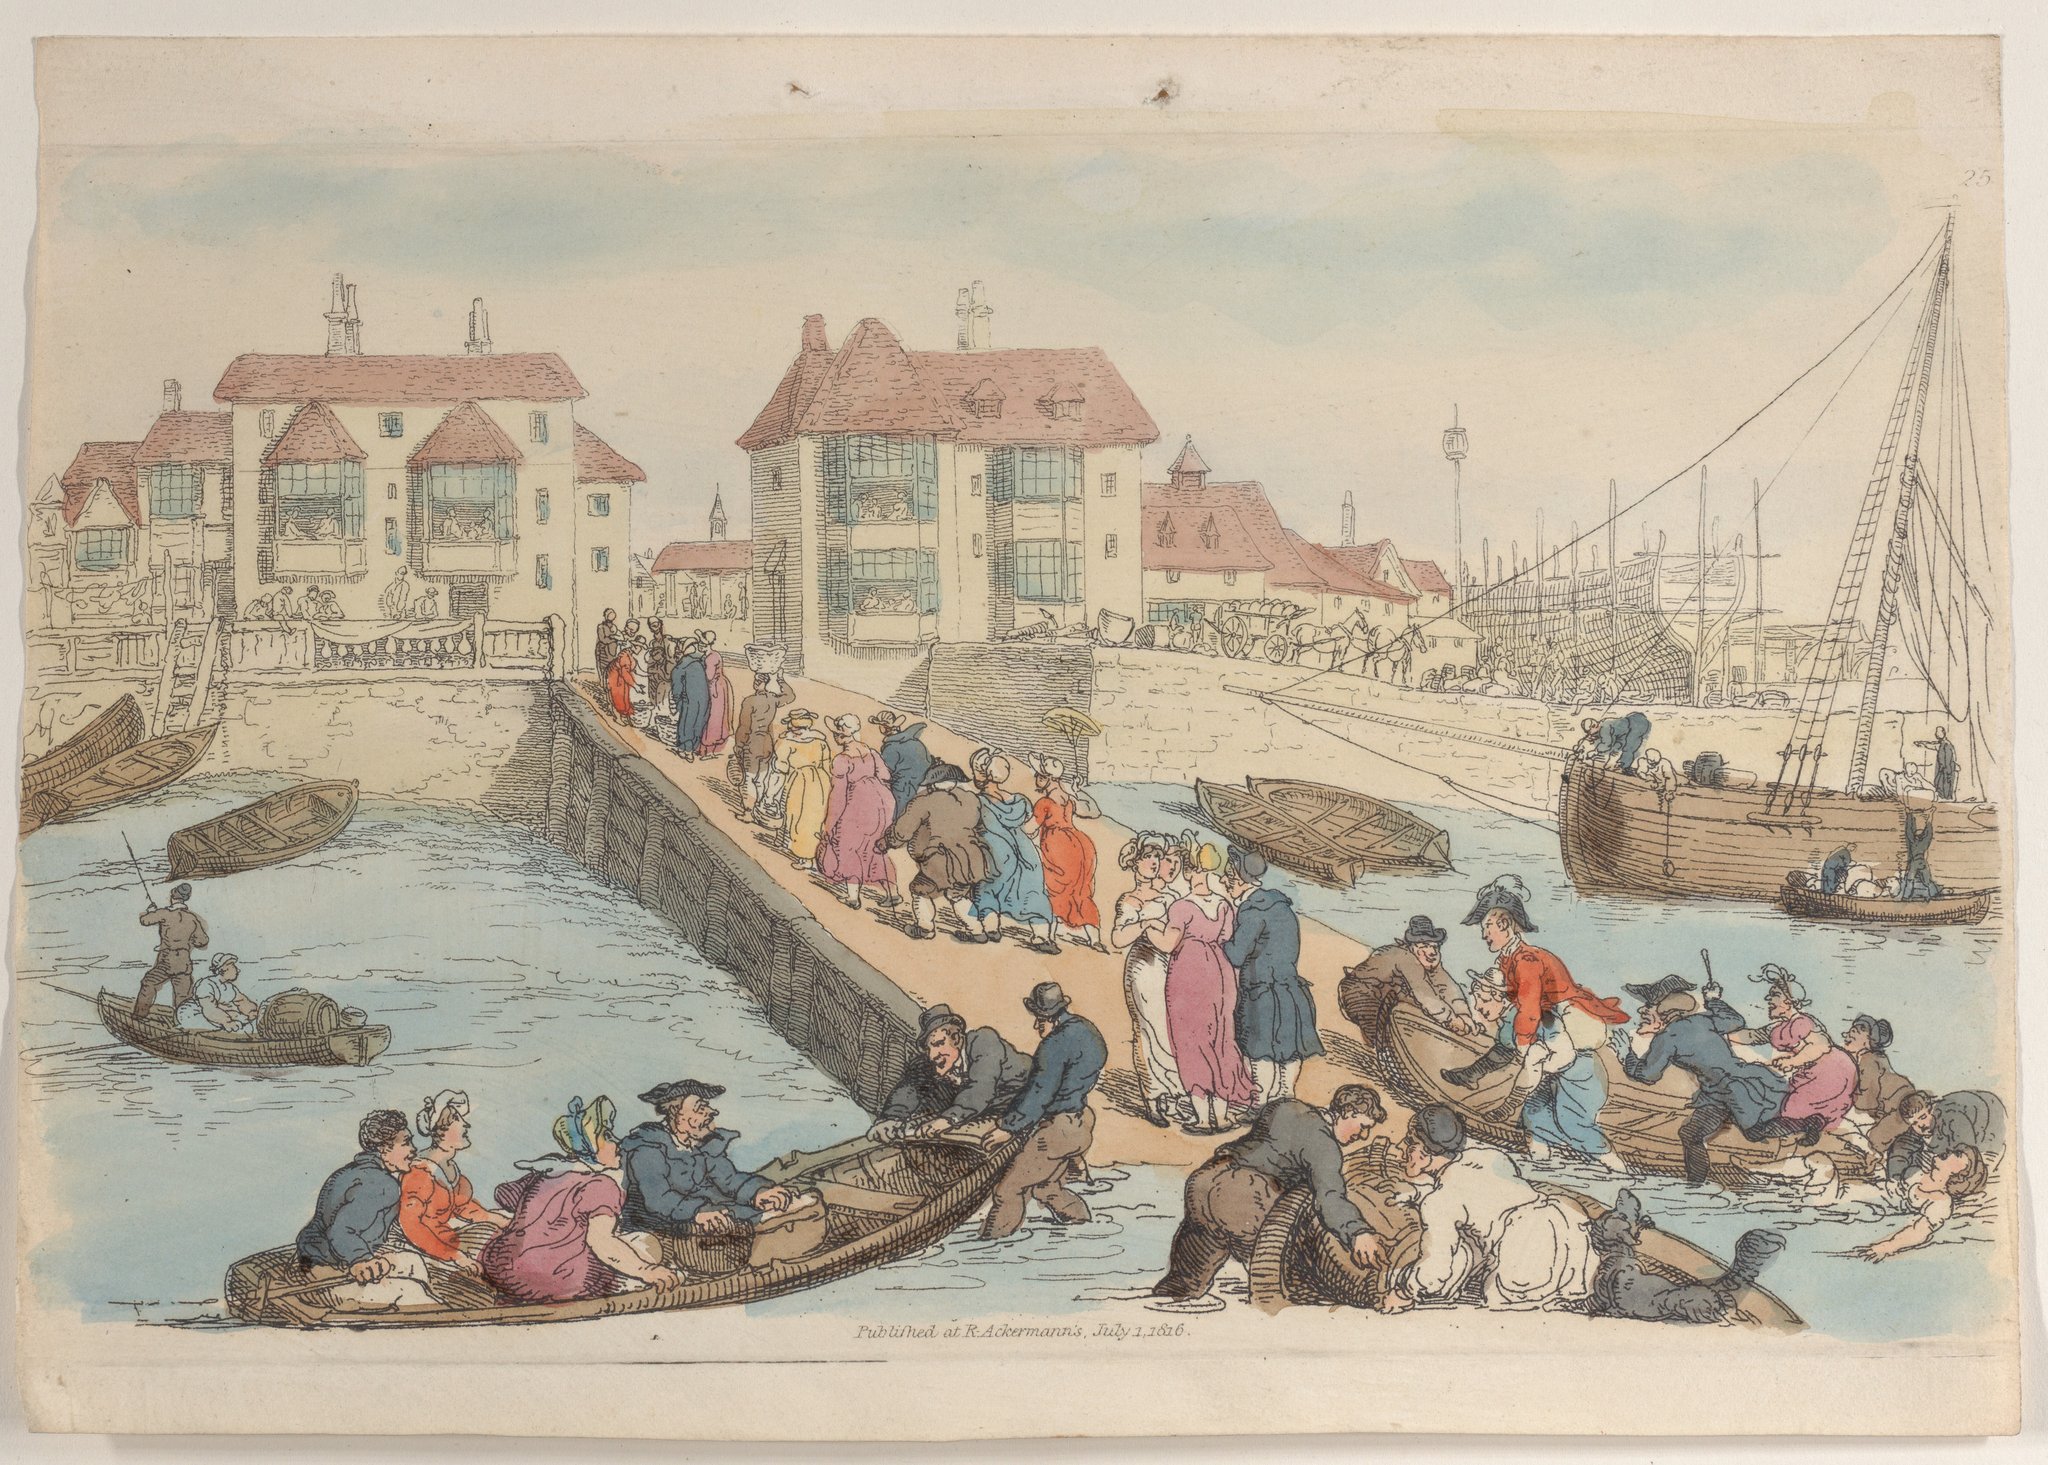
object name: print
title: Plate 25: A Landing Place, from "World in Miniature"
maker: thomas rowlandson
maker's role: artist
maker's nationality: british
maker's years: 1757-1827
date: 1816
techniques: etching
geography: london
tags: men,women,boats